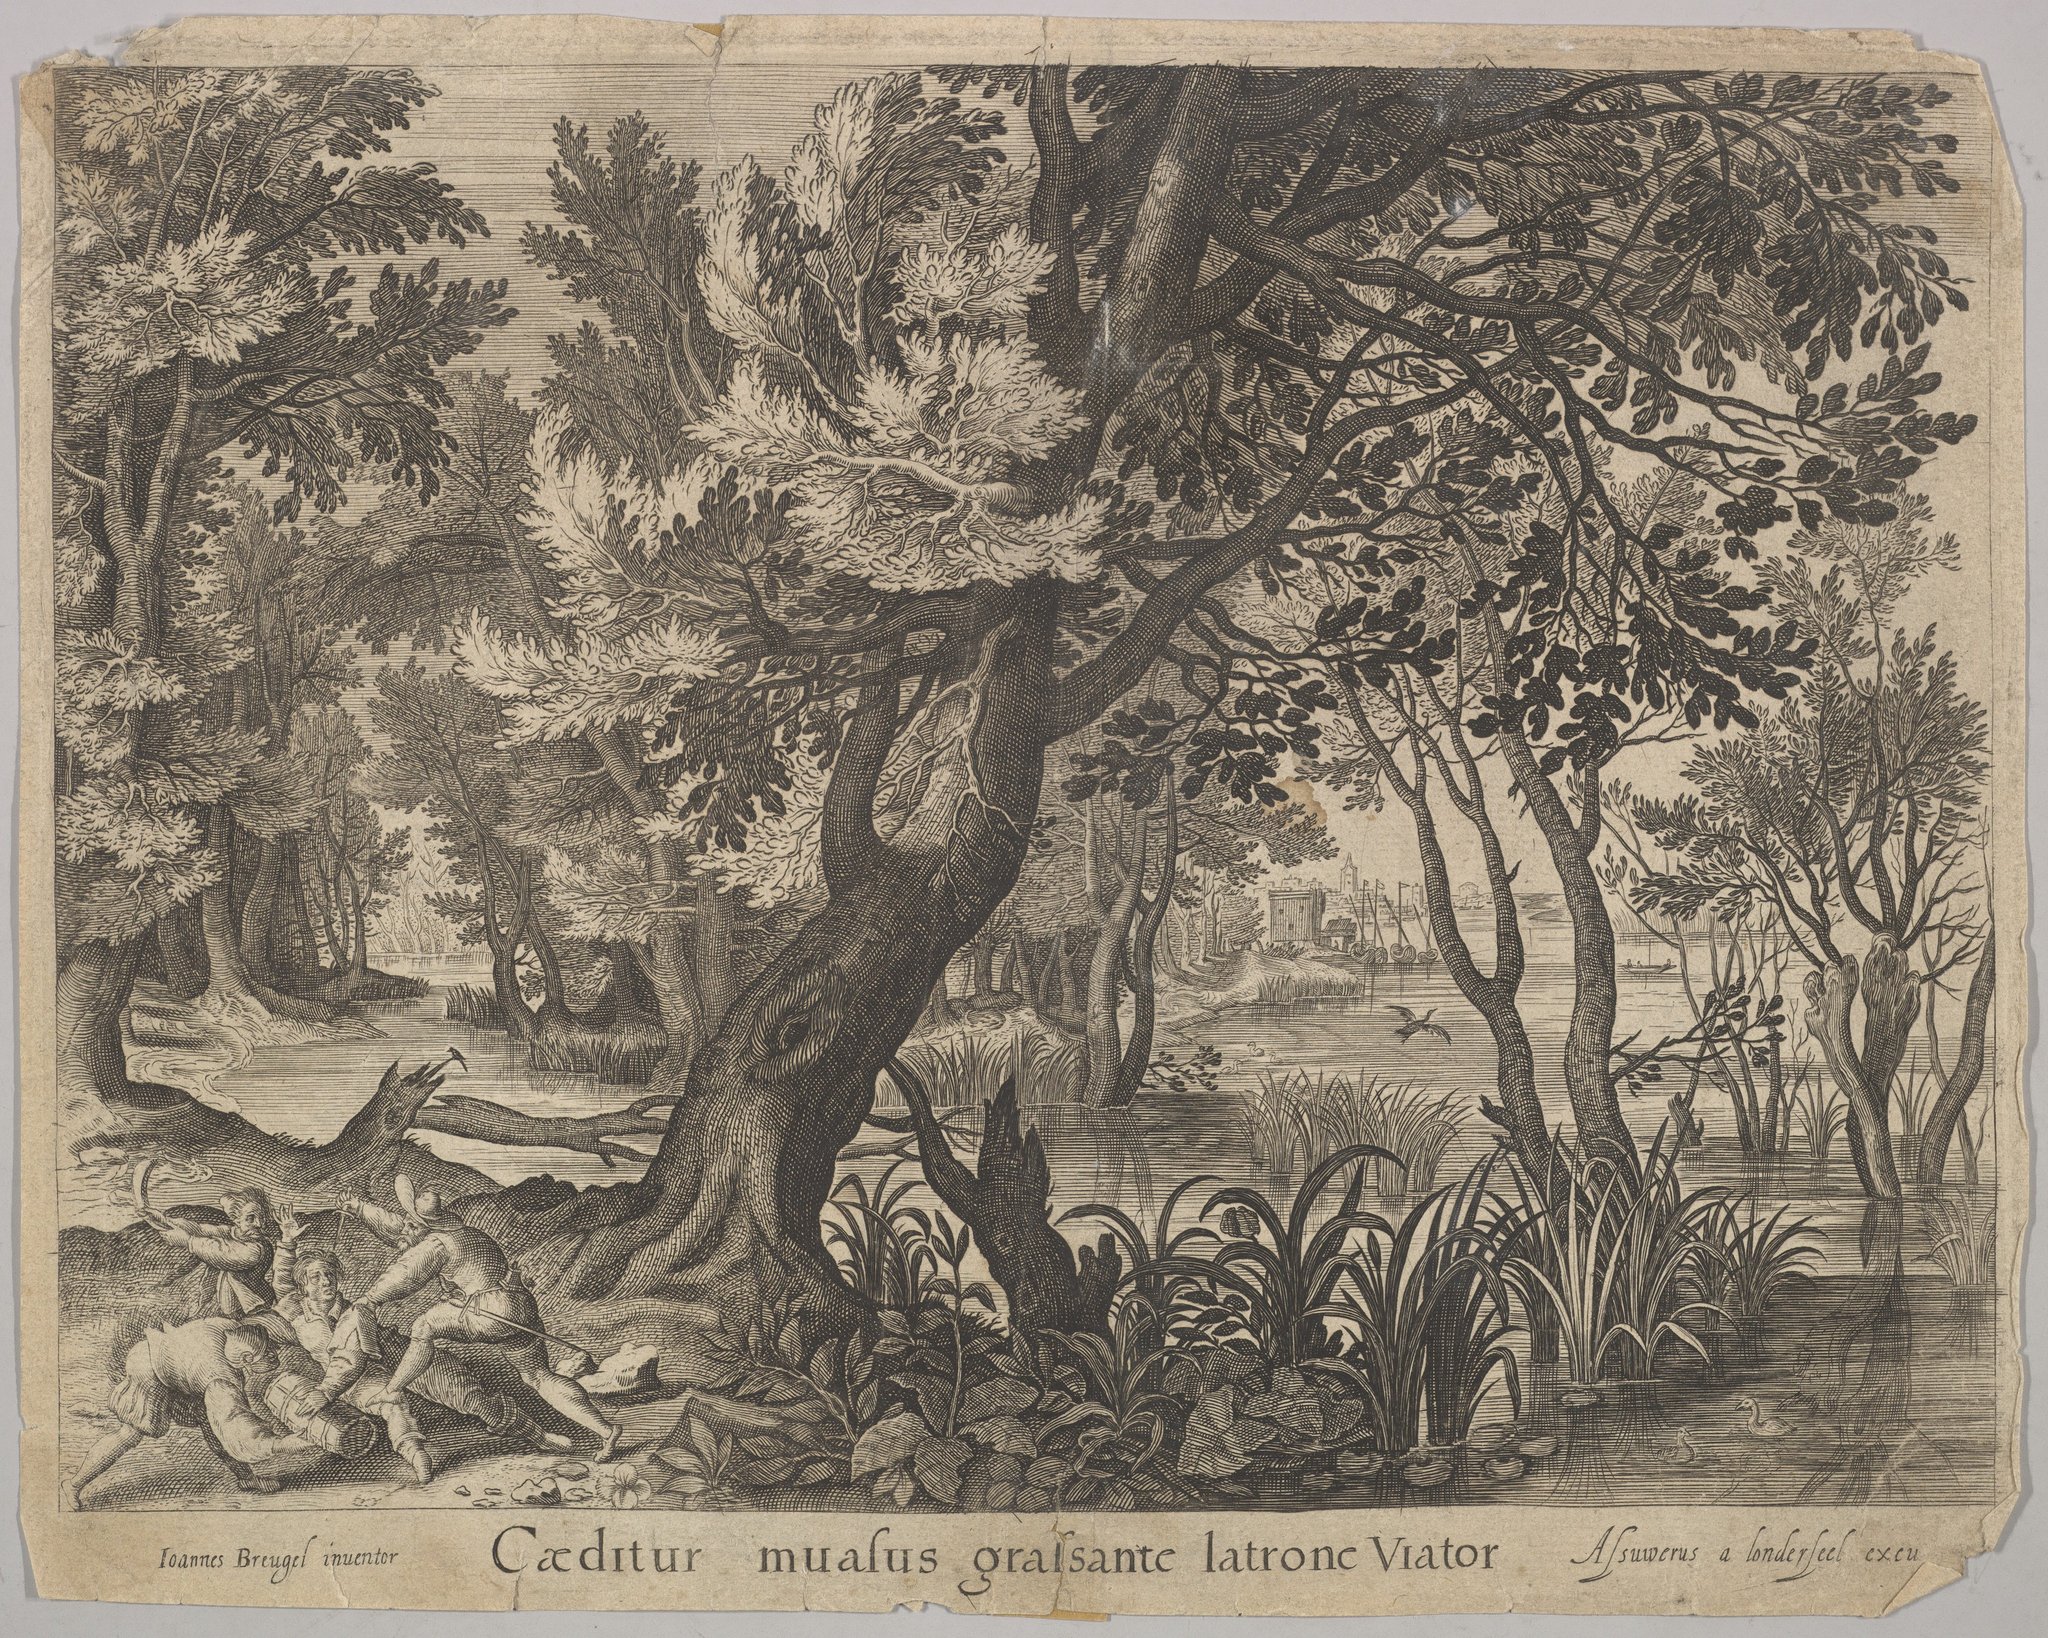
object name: print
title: The Thieves Robbing the Man from The Good Samaritan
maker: jan brueghel the elder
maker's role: artist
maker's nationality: netherlandish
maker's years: 1568-1625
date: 1593-1625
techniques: engraving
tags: men,landscapes